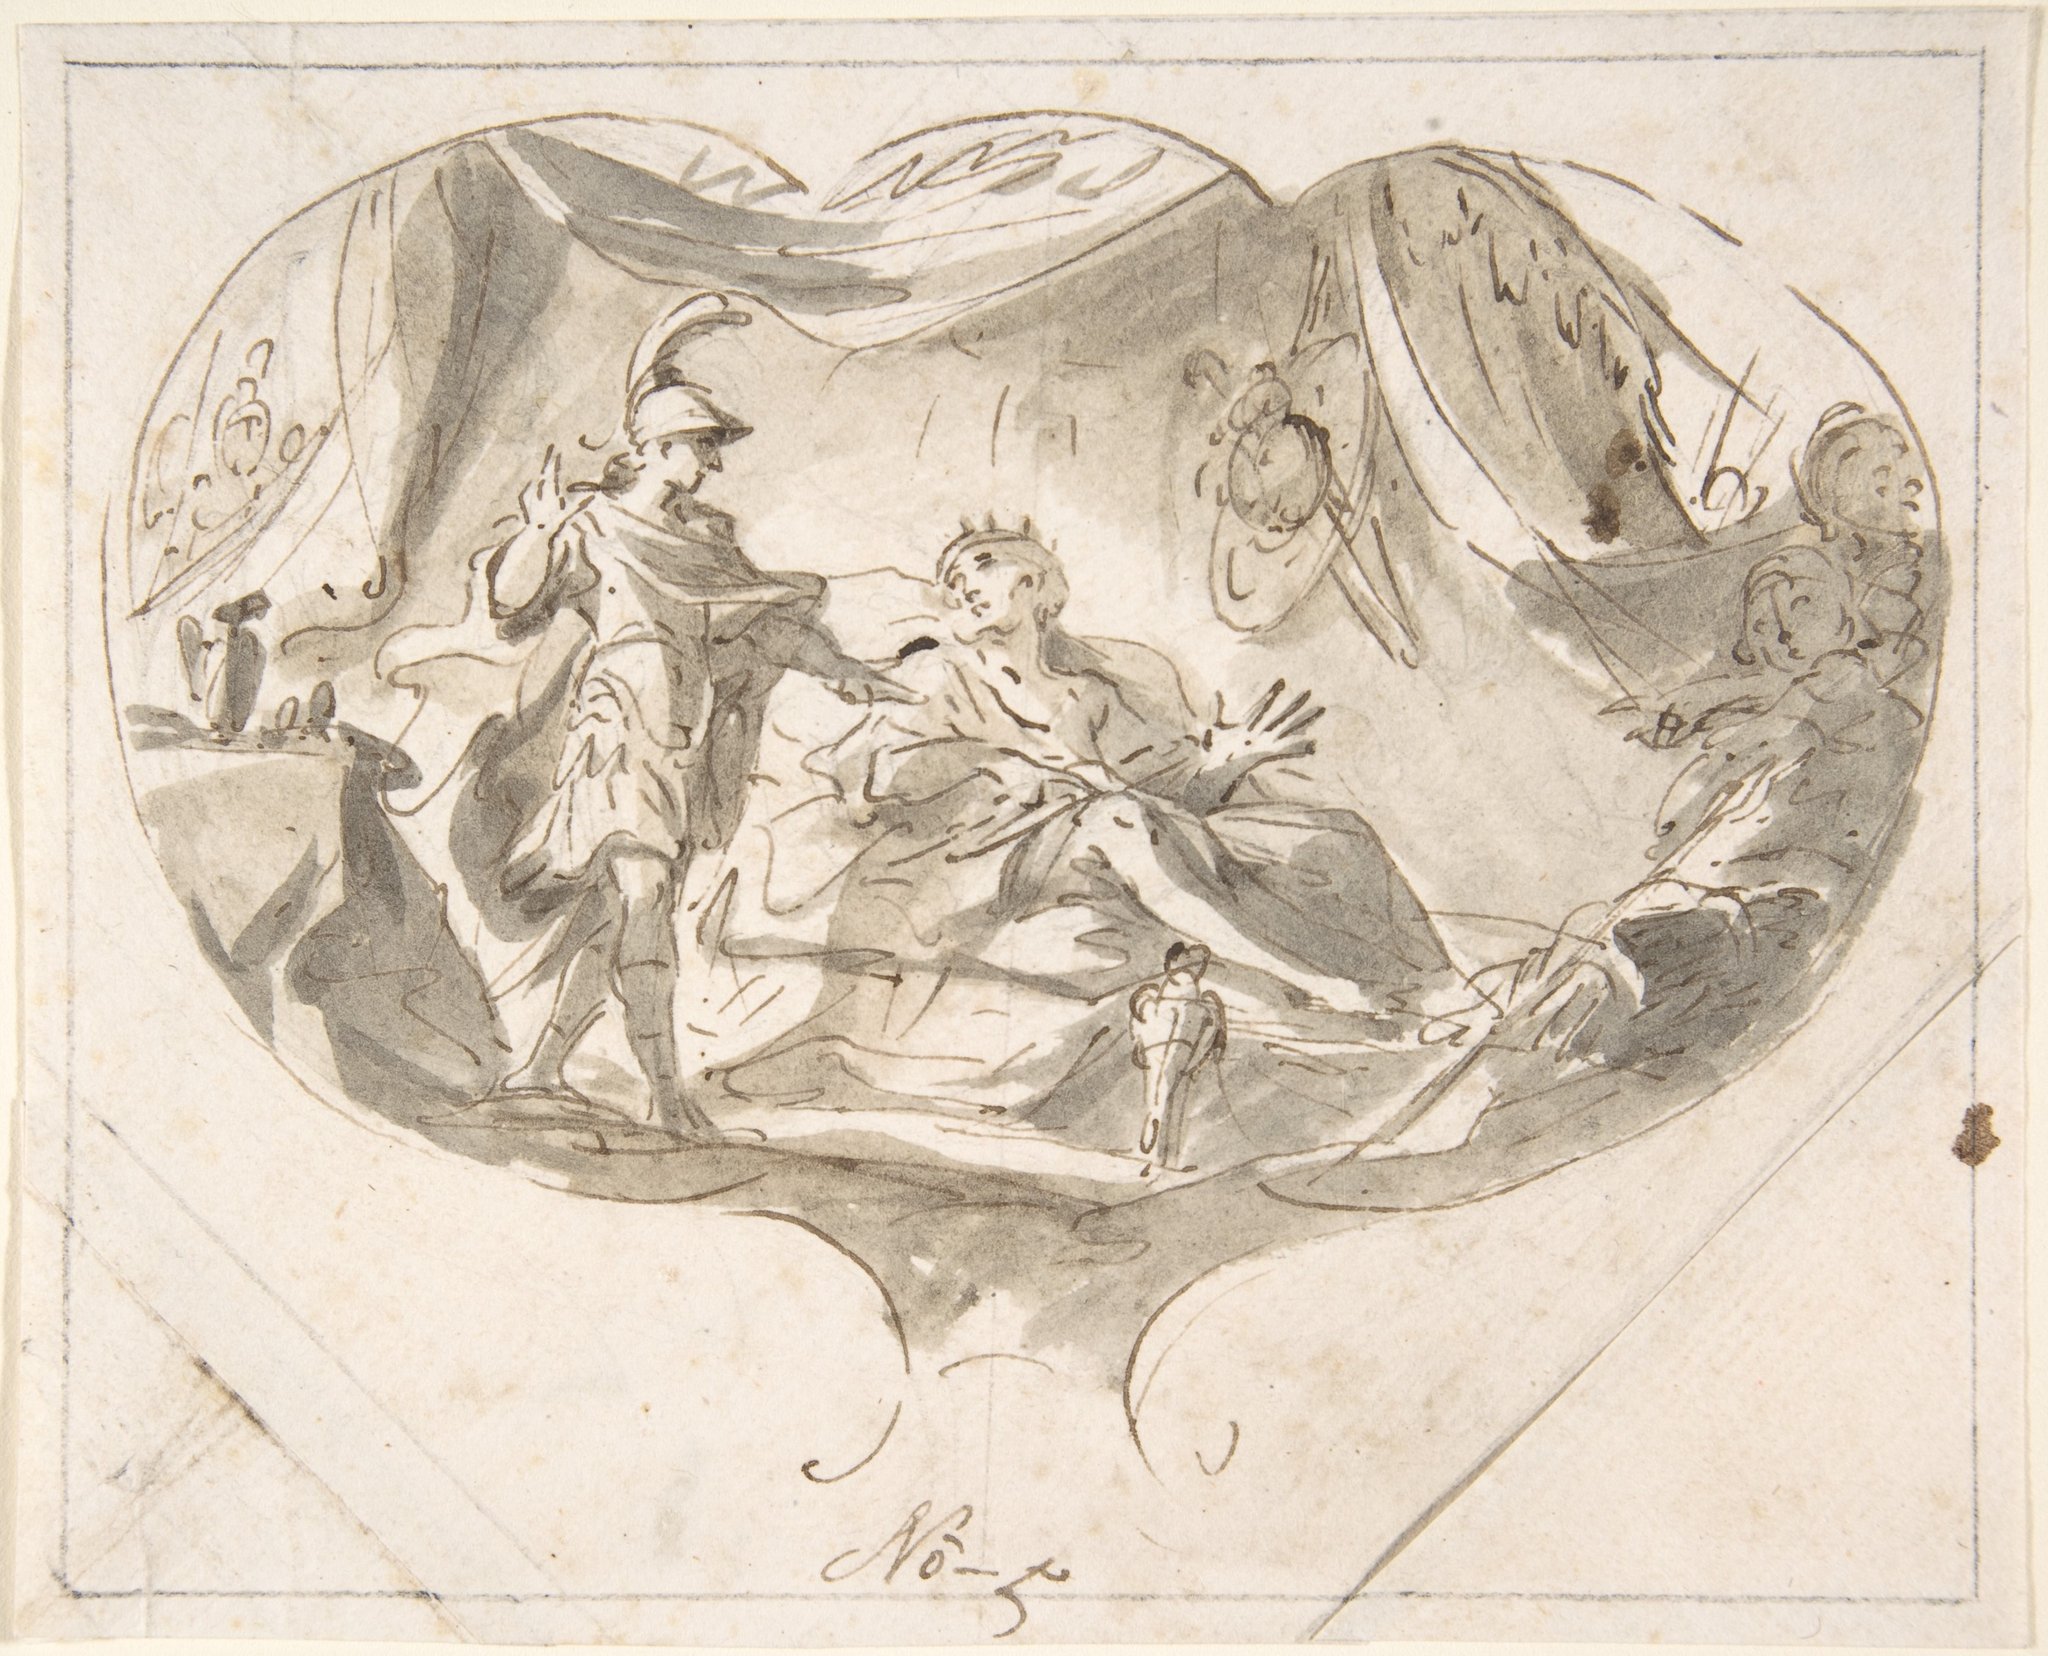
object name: drawing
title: Alexander the Great and King Poros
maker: martin altomonte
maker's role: artist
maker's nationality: italian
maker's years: 1657-1745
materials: ink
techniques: pen, wash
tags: alexander the great,kings